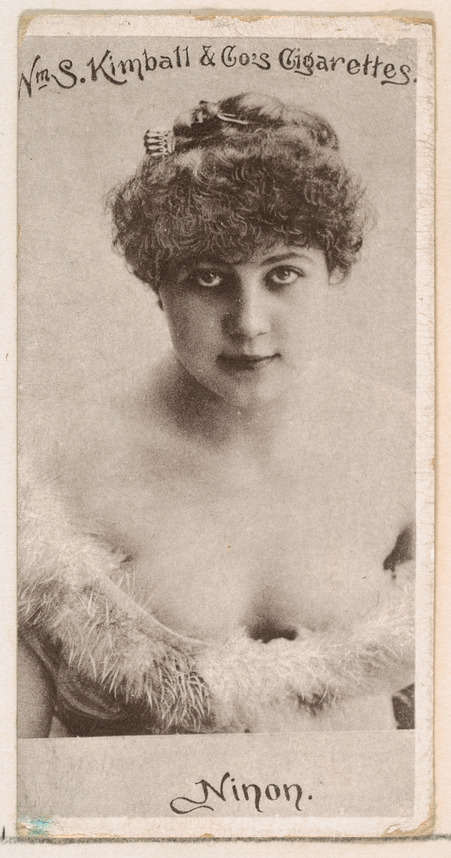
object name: print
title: Miss Ninon, from the Actresses series (N190) issued by Wm. S. Kimball & Co.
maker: william s. kimball & company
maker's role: publisher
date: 1889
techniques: lithography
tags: portraits,women,actresses